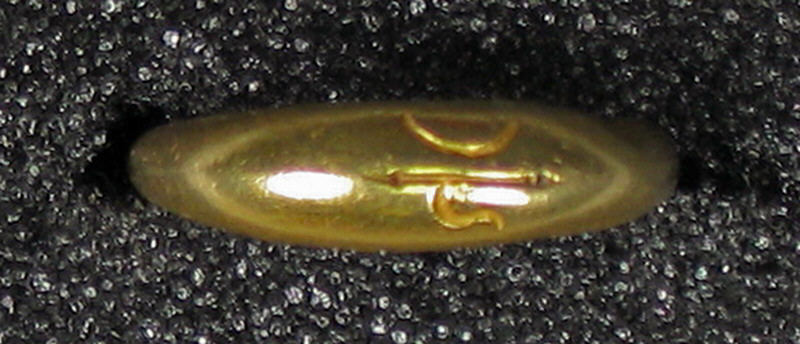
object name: ring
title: Ring with Round Bezel, Incised Calligraphy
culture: indonesian, central java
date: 701-1200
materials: gold